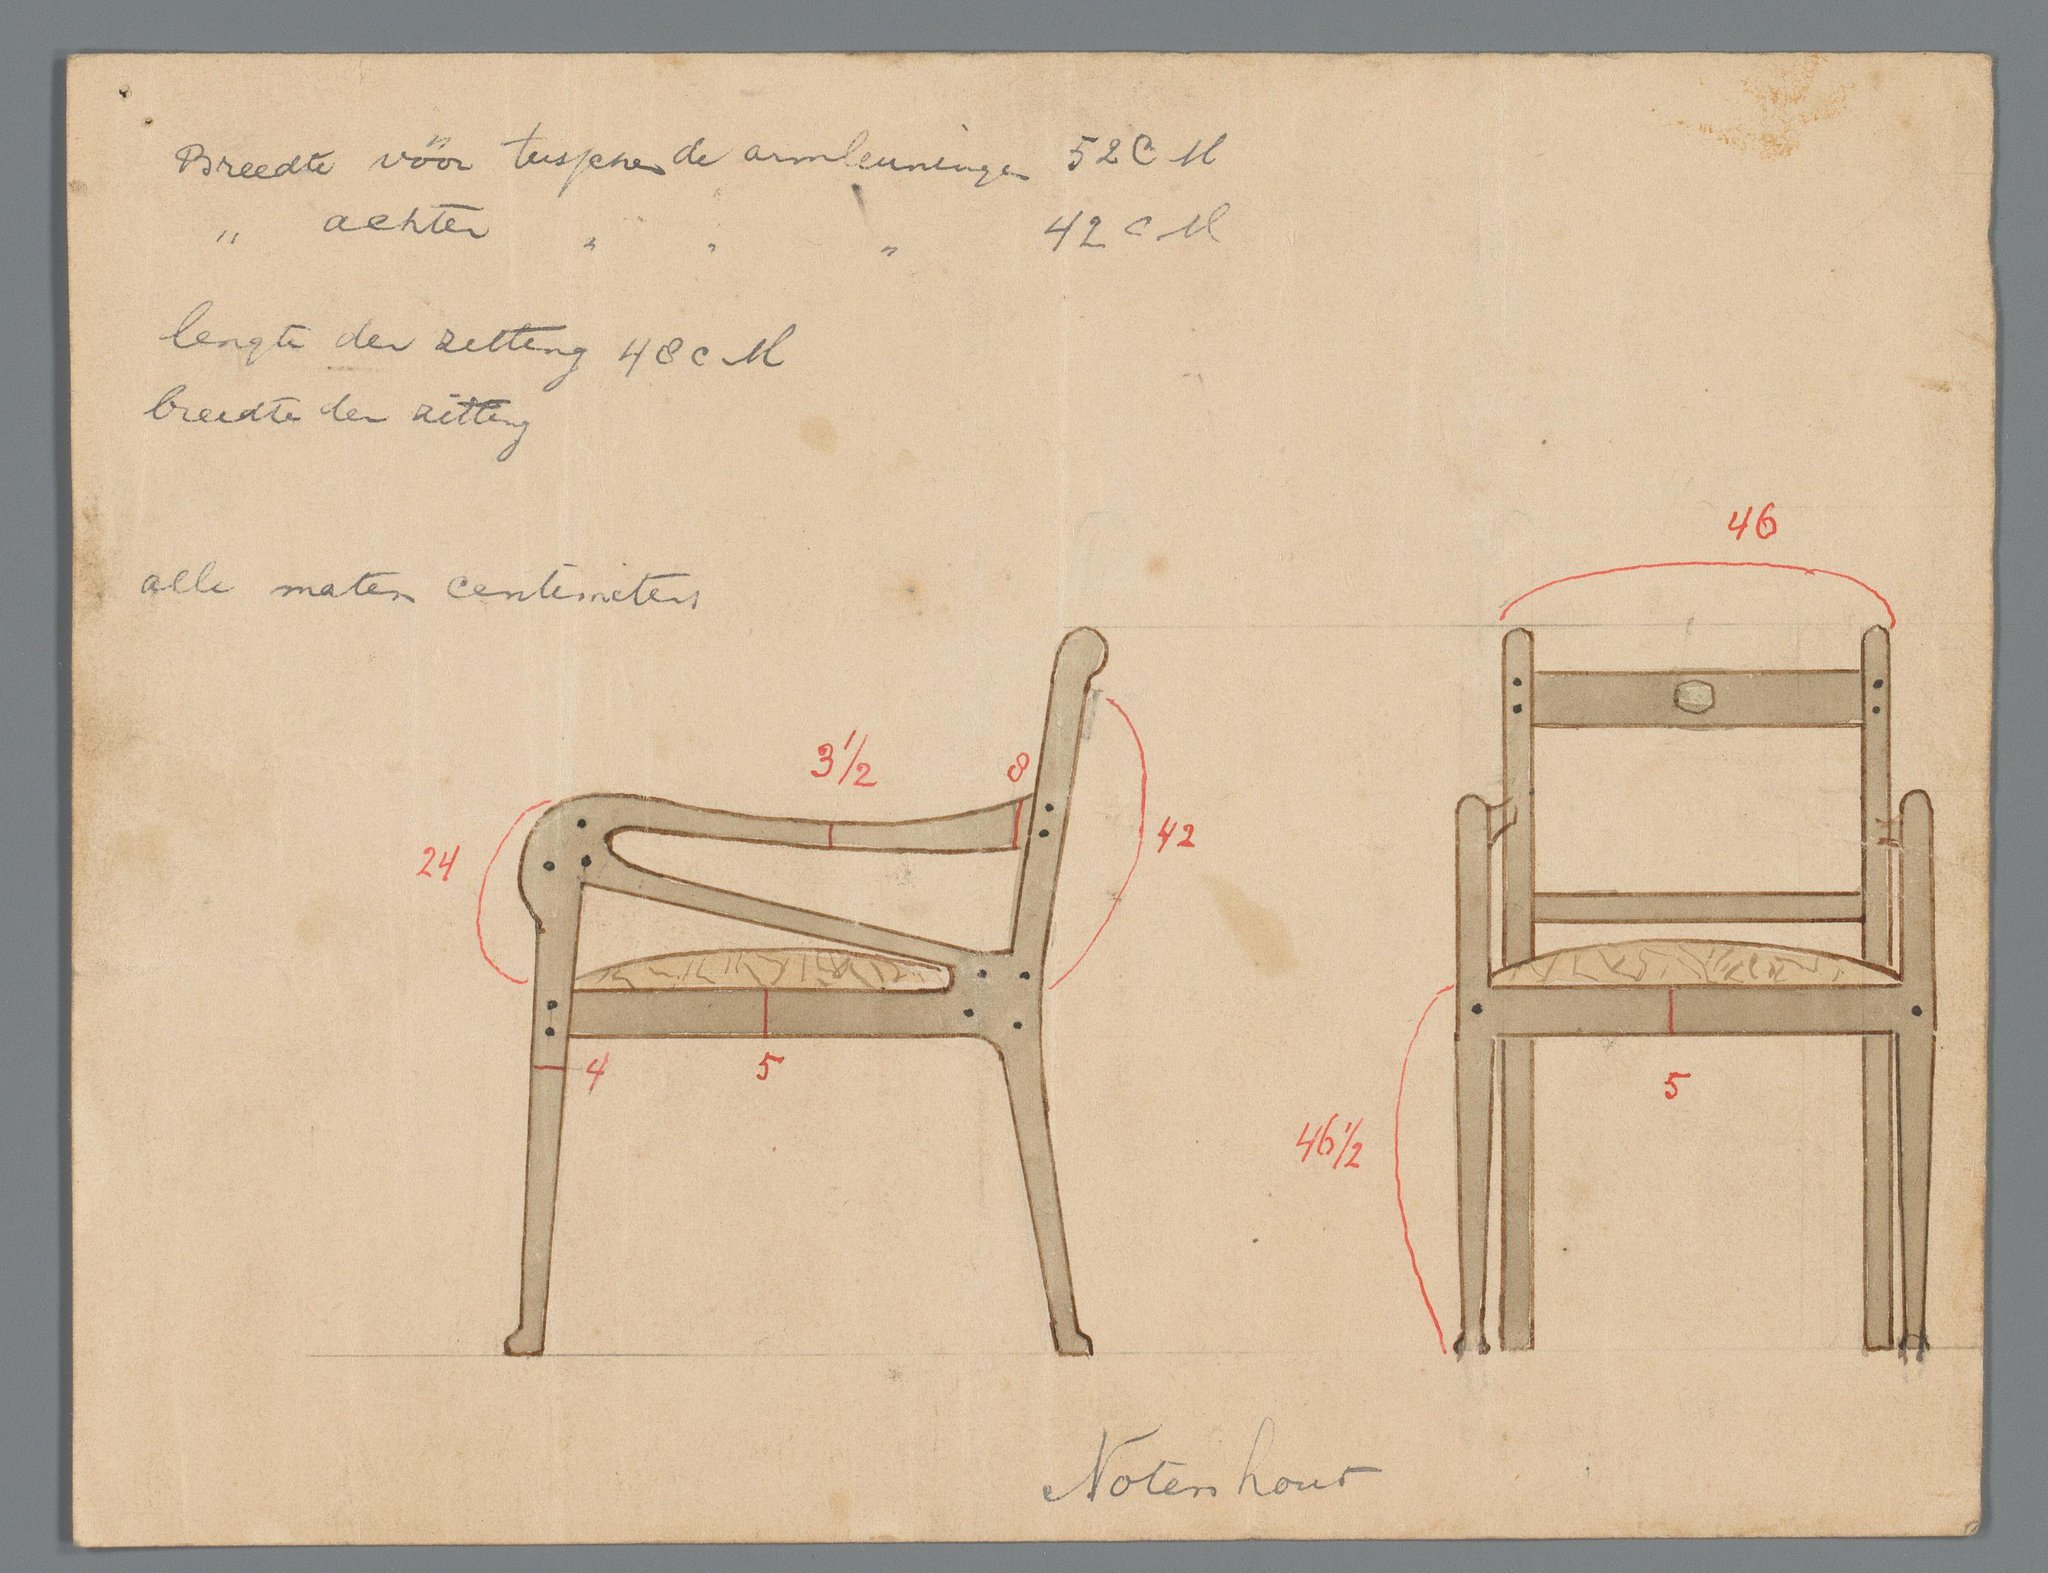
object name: design drawing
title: Ontwerp voor een stoel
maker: gust van de wall perné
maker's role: draughtsman, painter, print maker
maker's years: 1877-1911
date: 1887-1911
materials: paper, pencil, watercolor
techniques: brush, pen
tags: chair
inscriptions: collector's mark: Lugt 2228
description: Voor- en zijaanzicht. Met aantekeningen over de afmetingen en het materiaal.